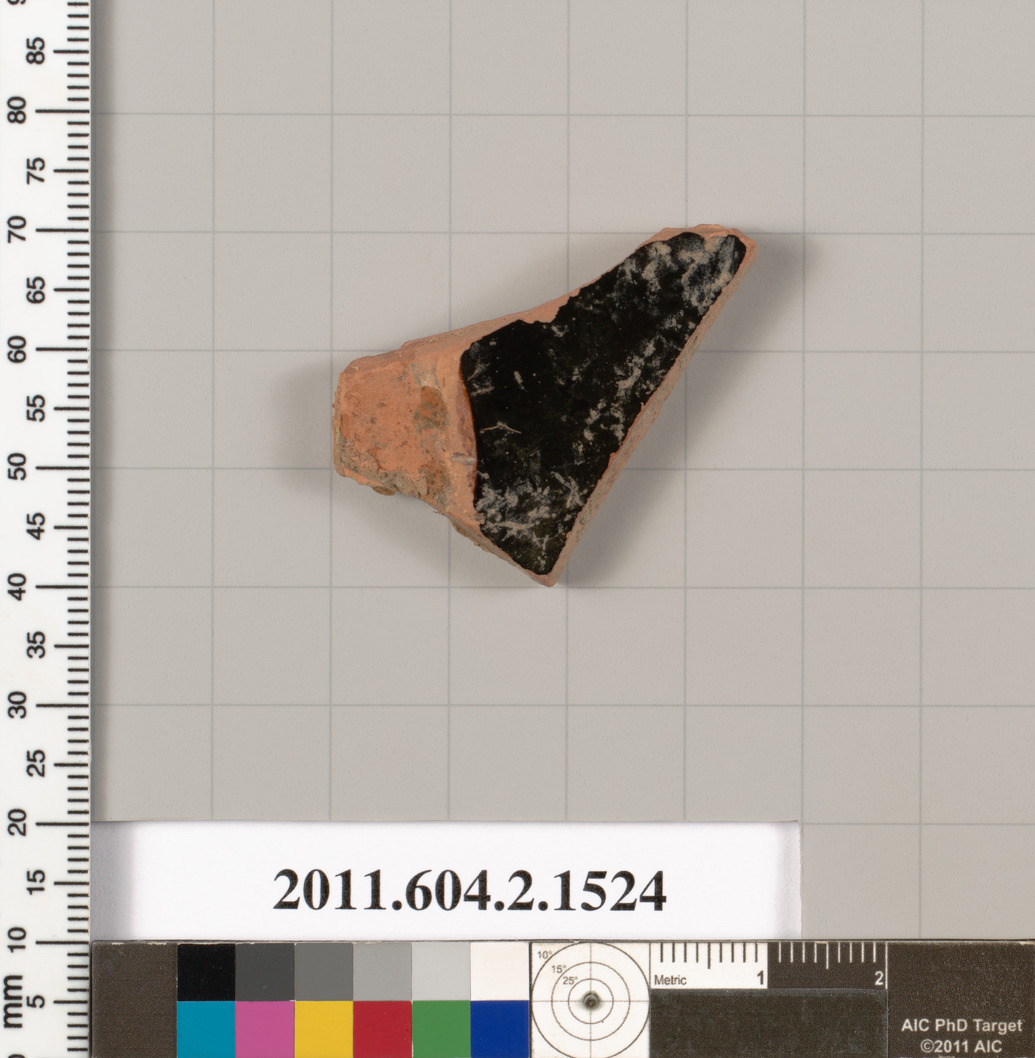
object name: skyphos fragment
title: Terracotta fragment of a skyphos (deep drinking cup)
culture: greek, attic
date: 600-401 BCE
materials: terracotta